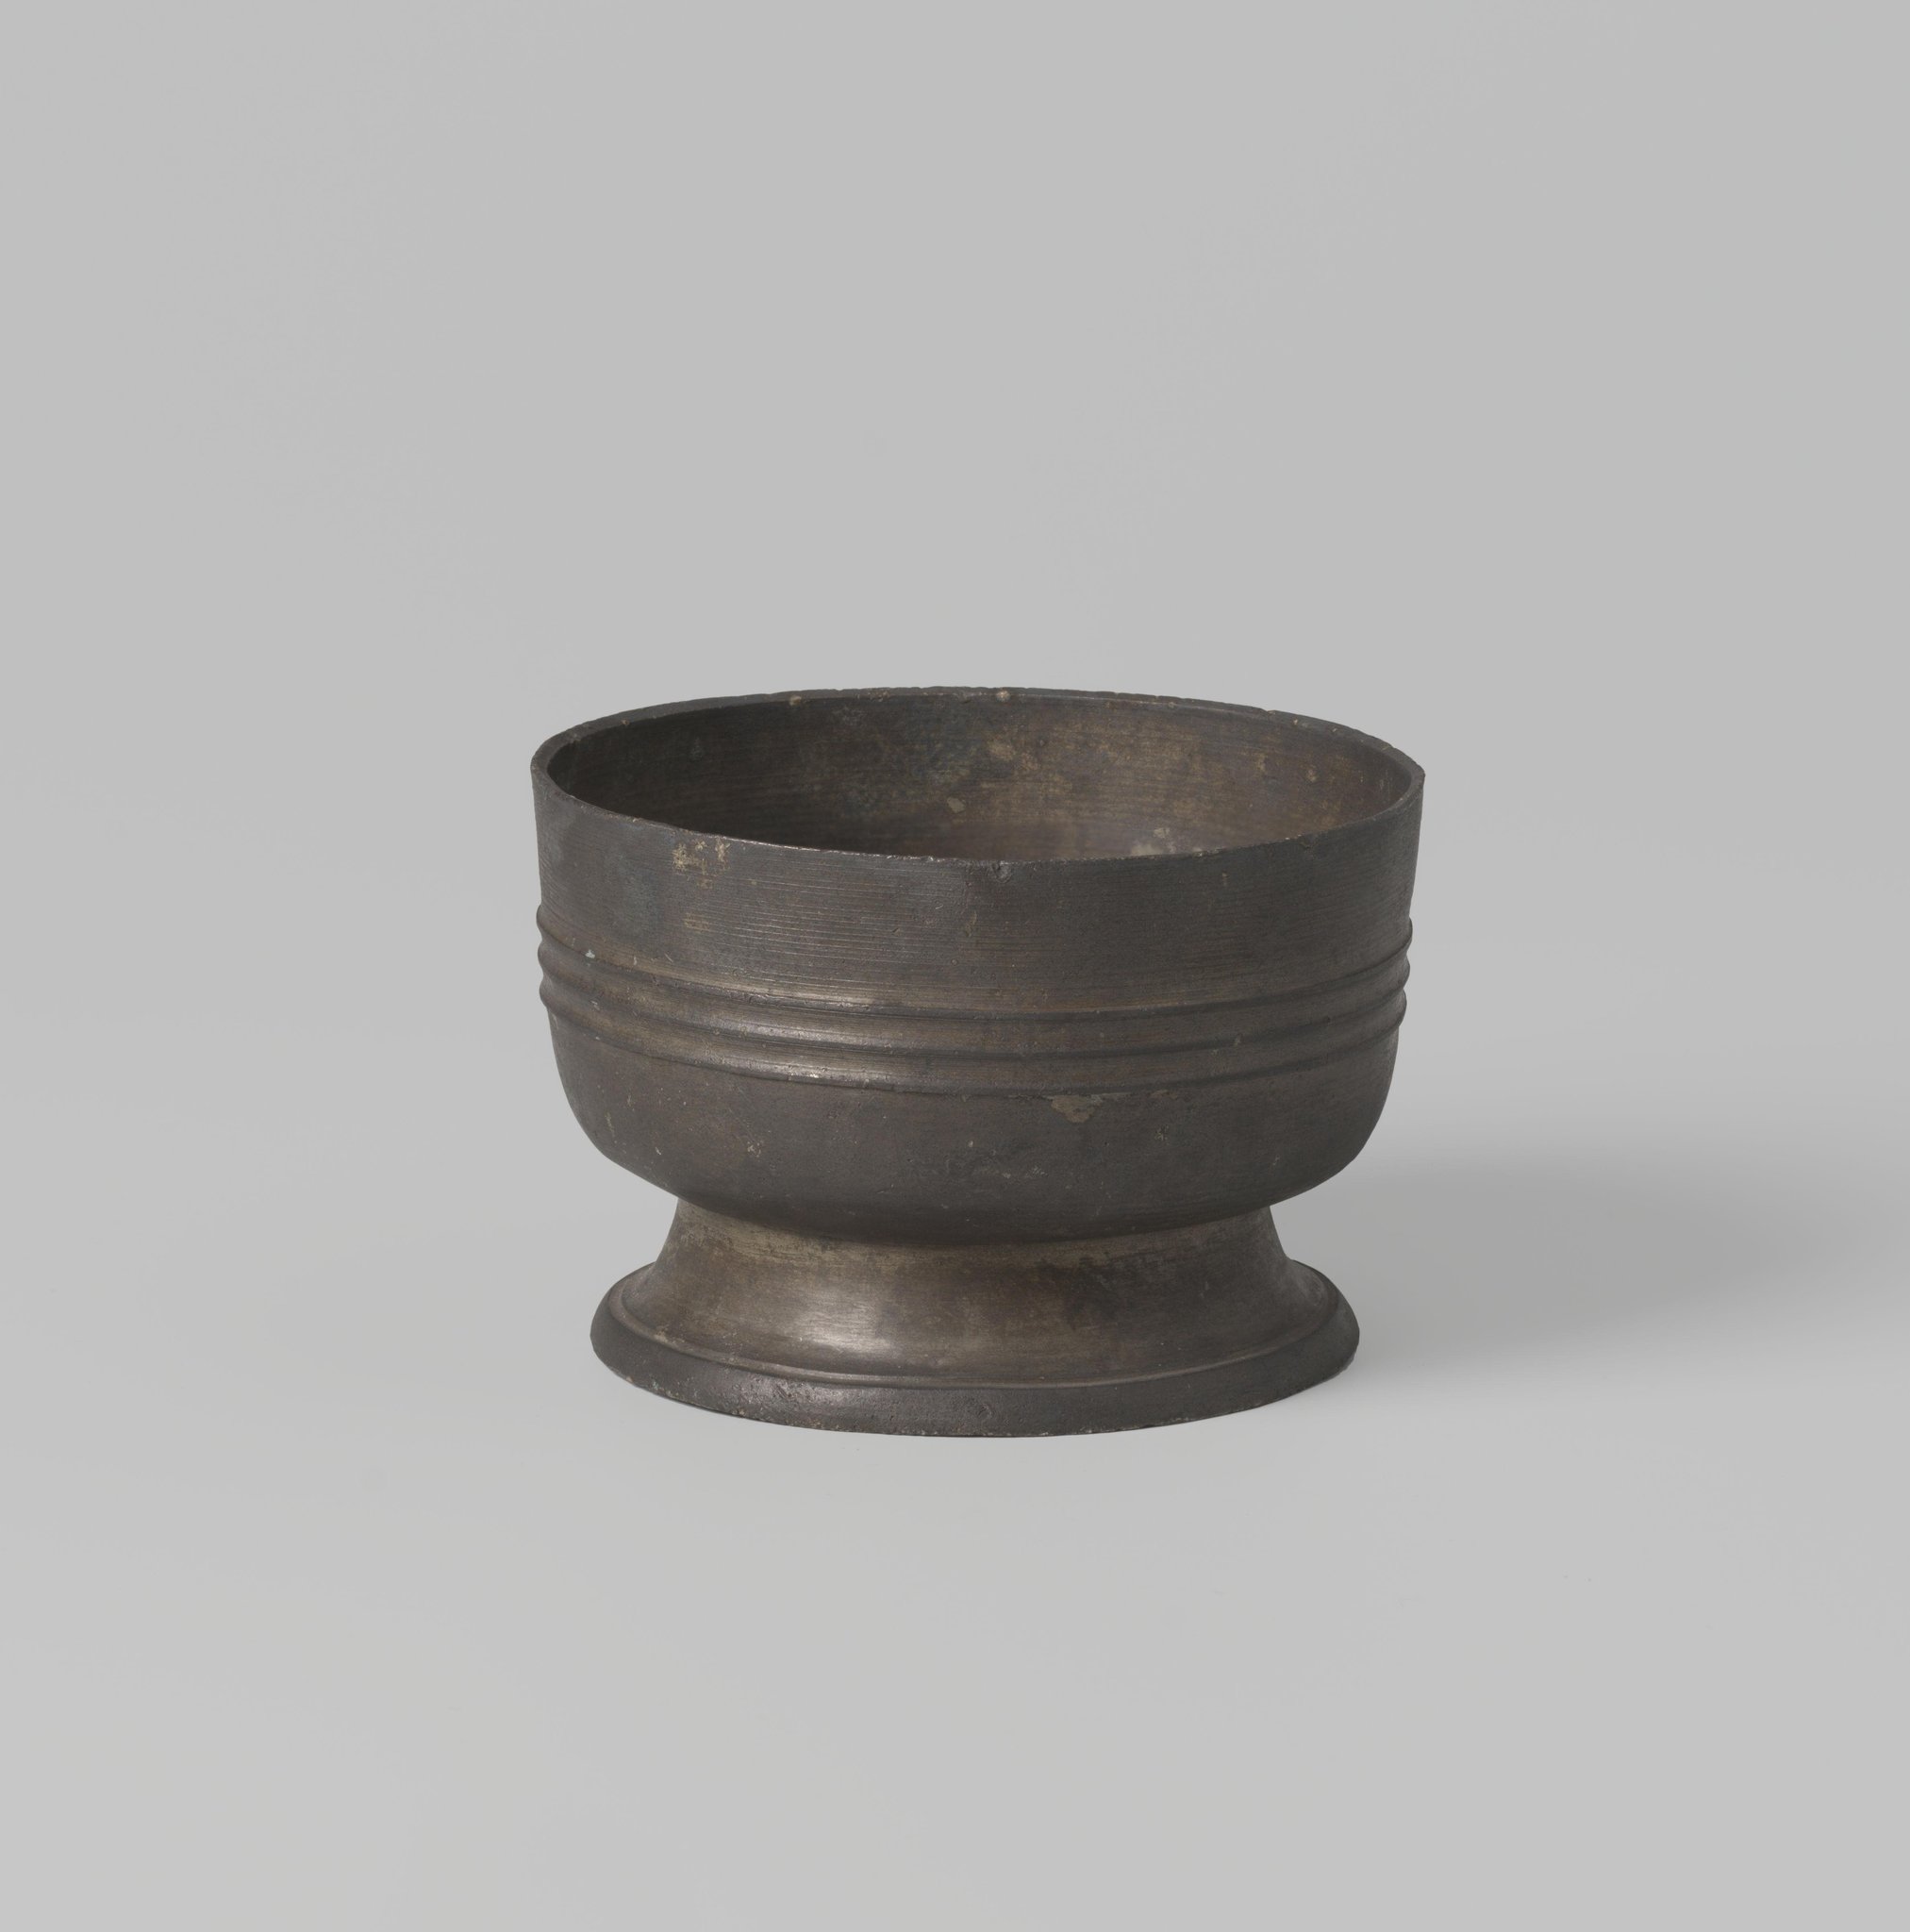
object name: kroes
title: Kroes van tin met concave, iets geprofileerde standring. De cuppa vertoont drie profielbanden.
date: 1580-1600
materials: tin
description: Kroes van tin met concave, iets geprofileerde standring. De cuppa vertoont drie profielbanden.